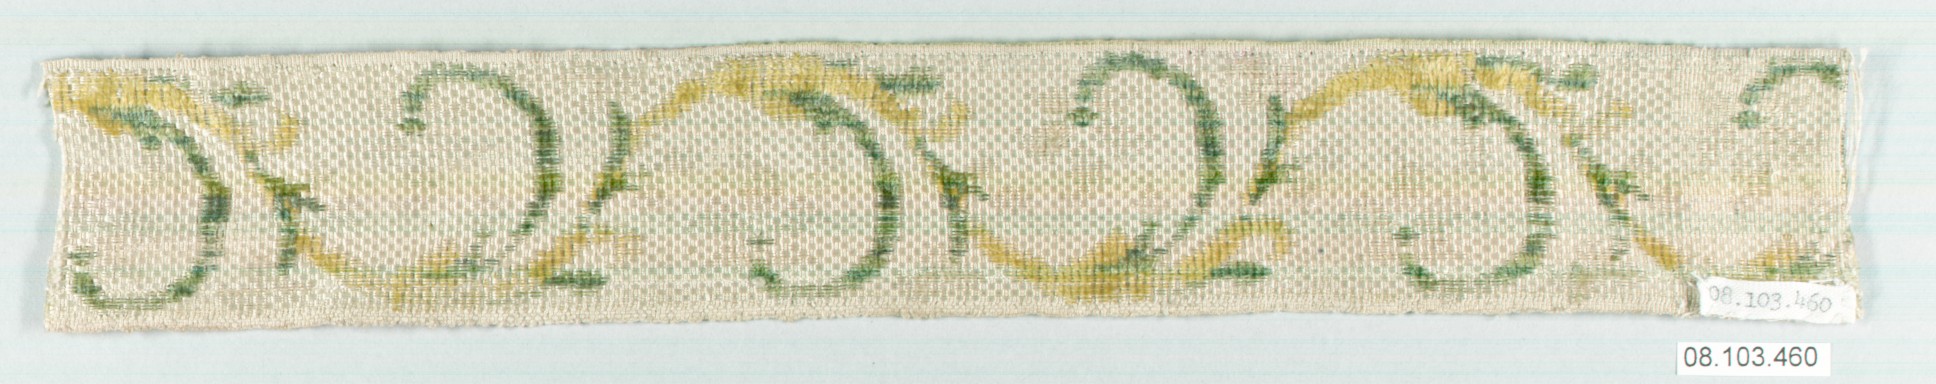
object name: galloon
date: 1801-1833